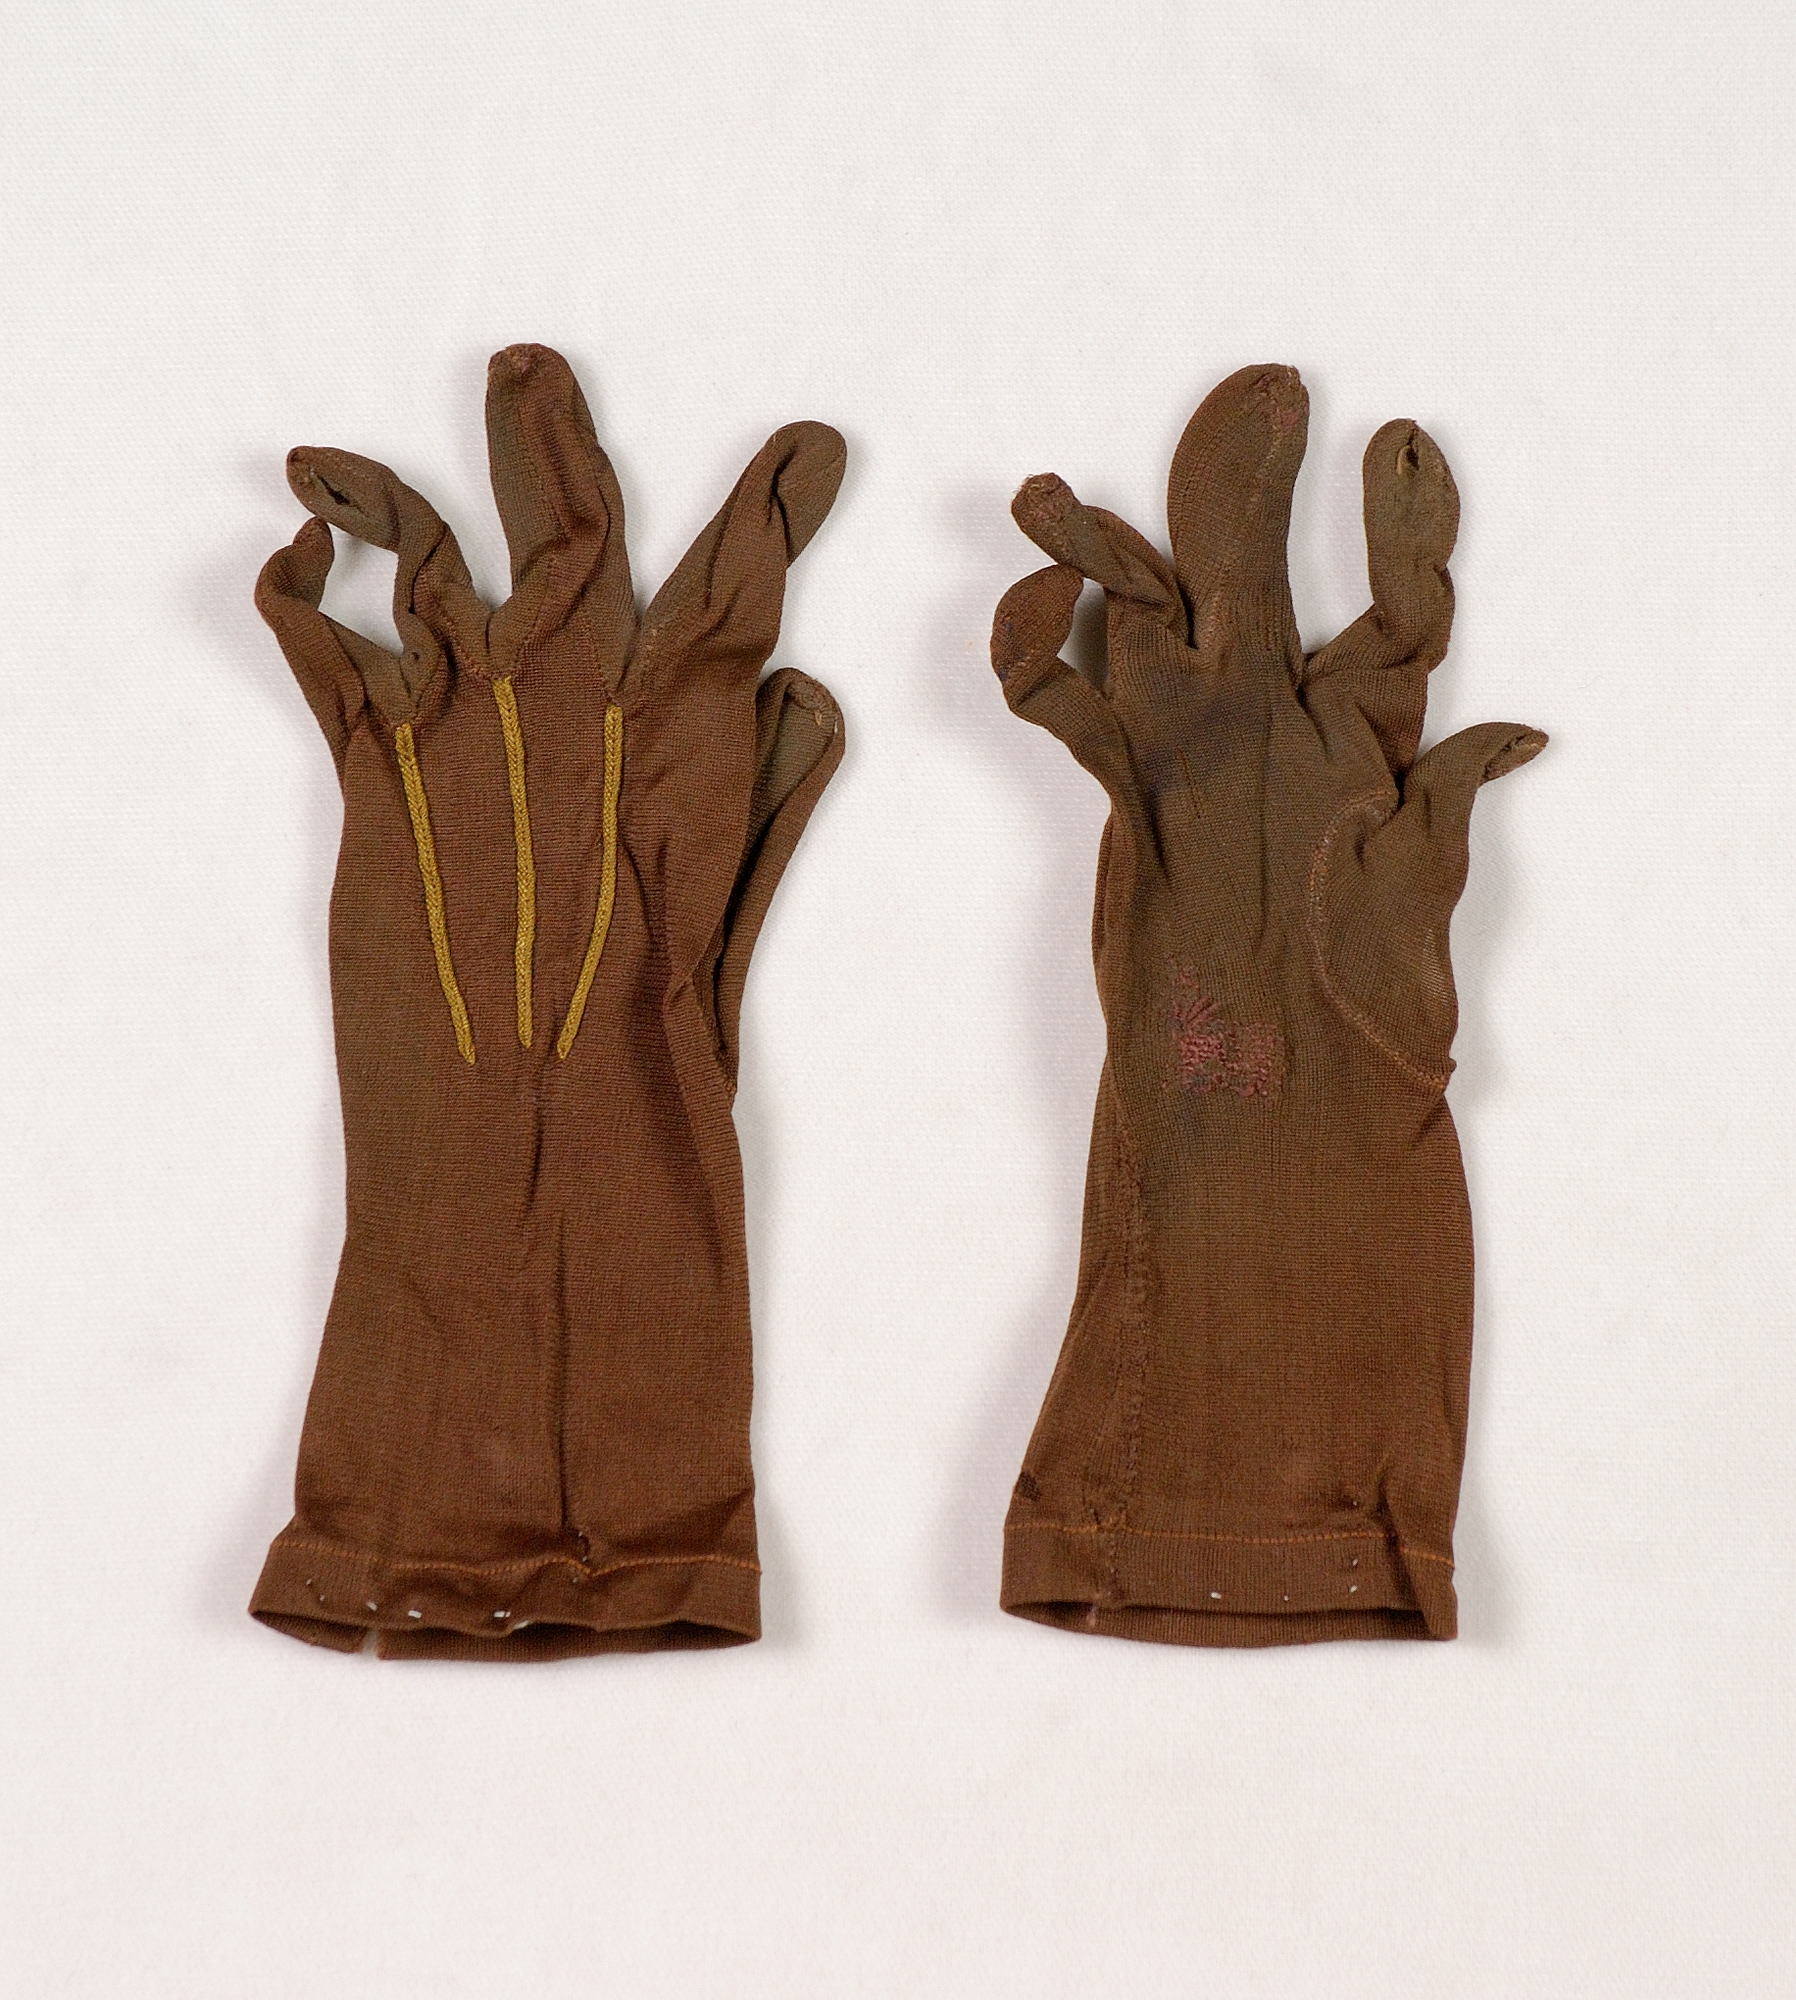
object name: glove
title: Gloves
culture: american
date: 1888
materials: silk